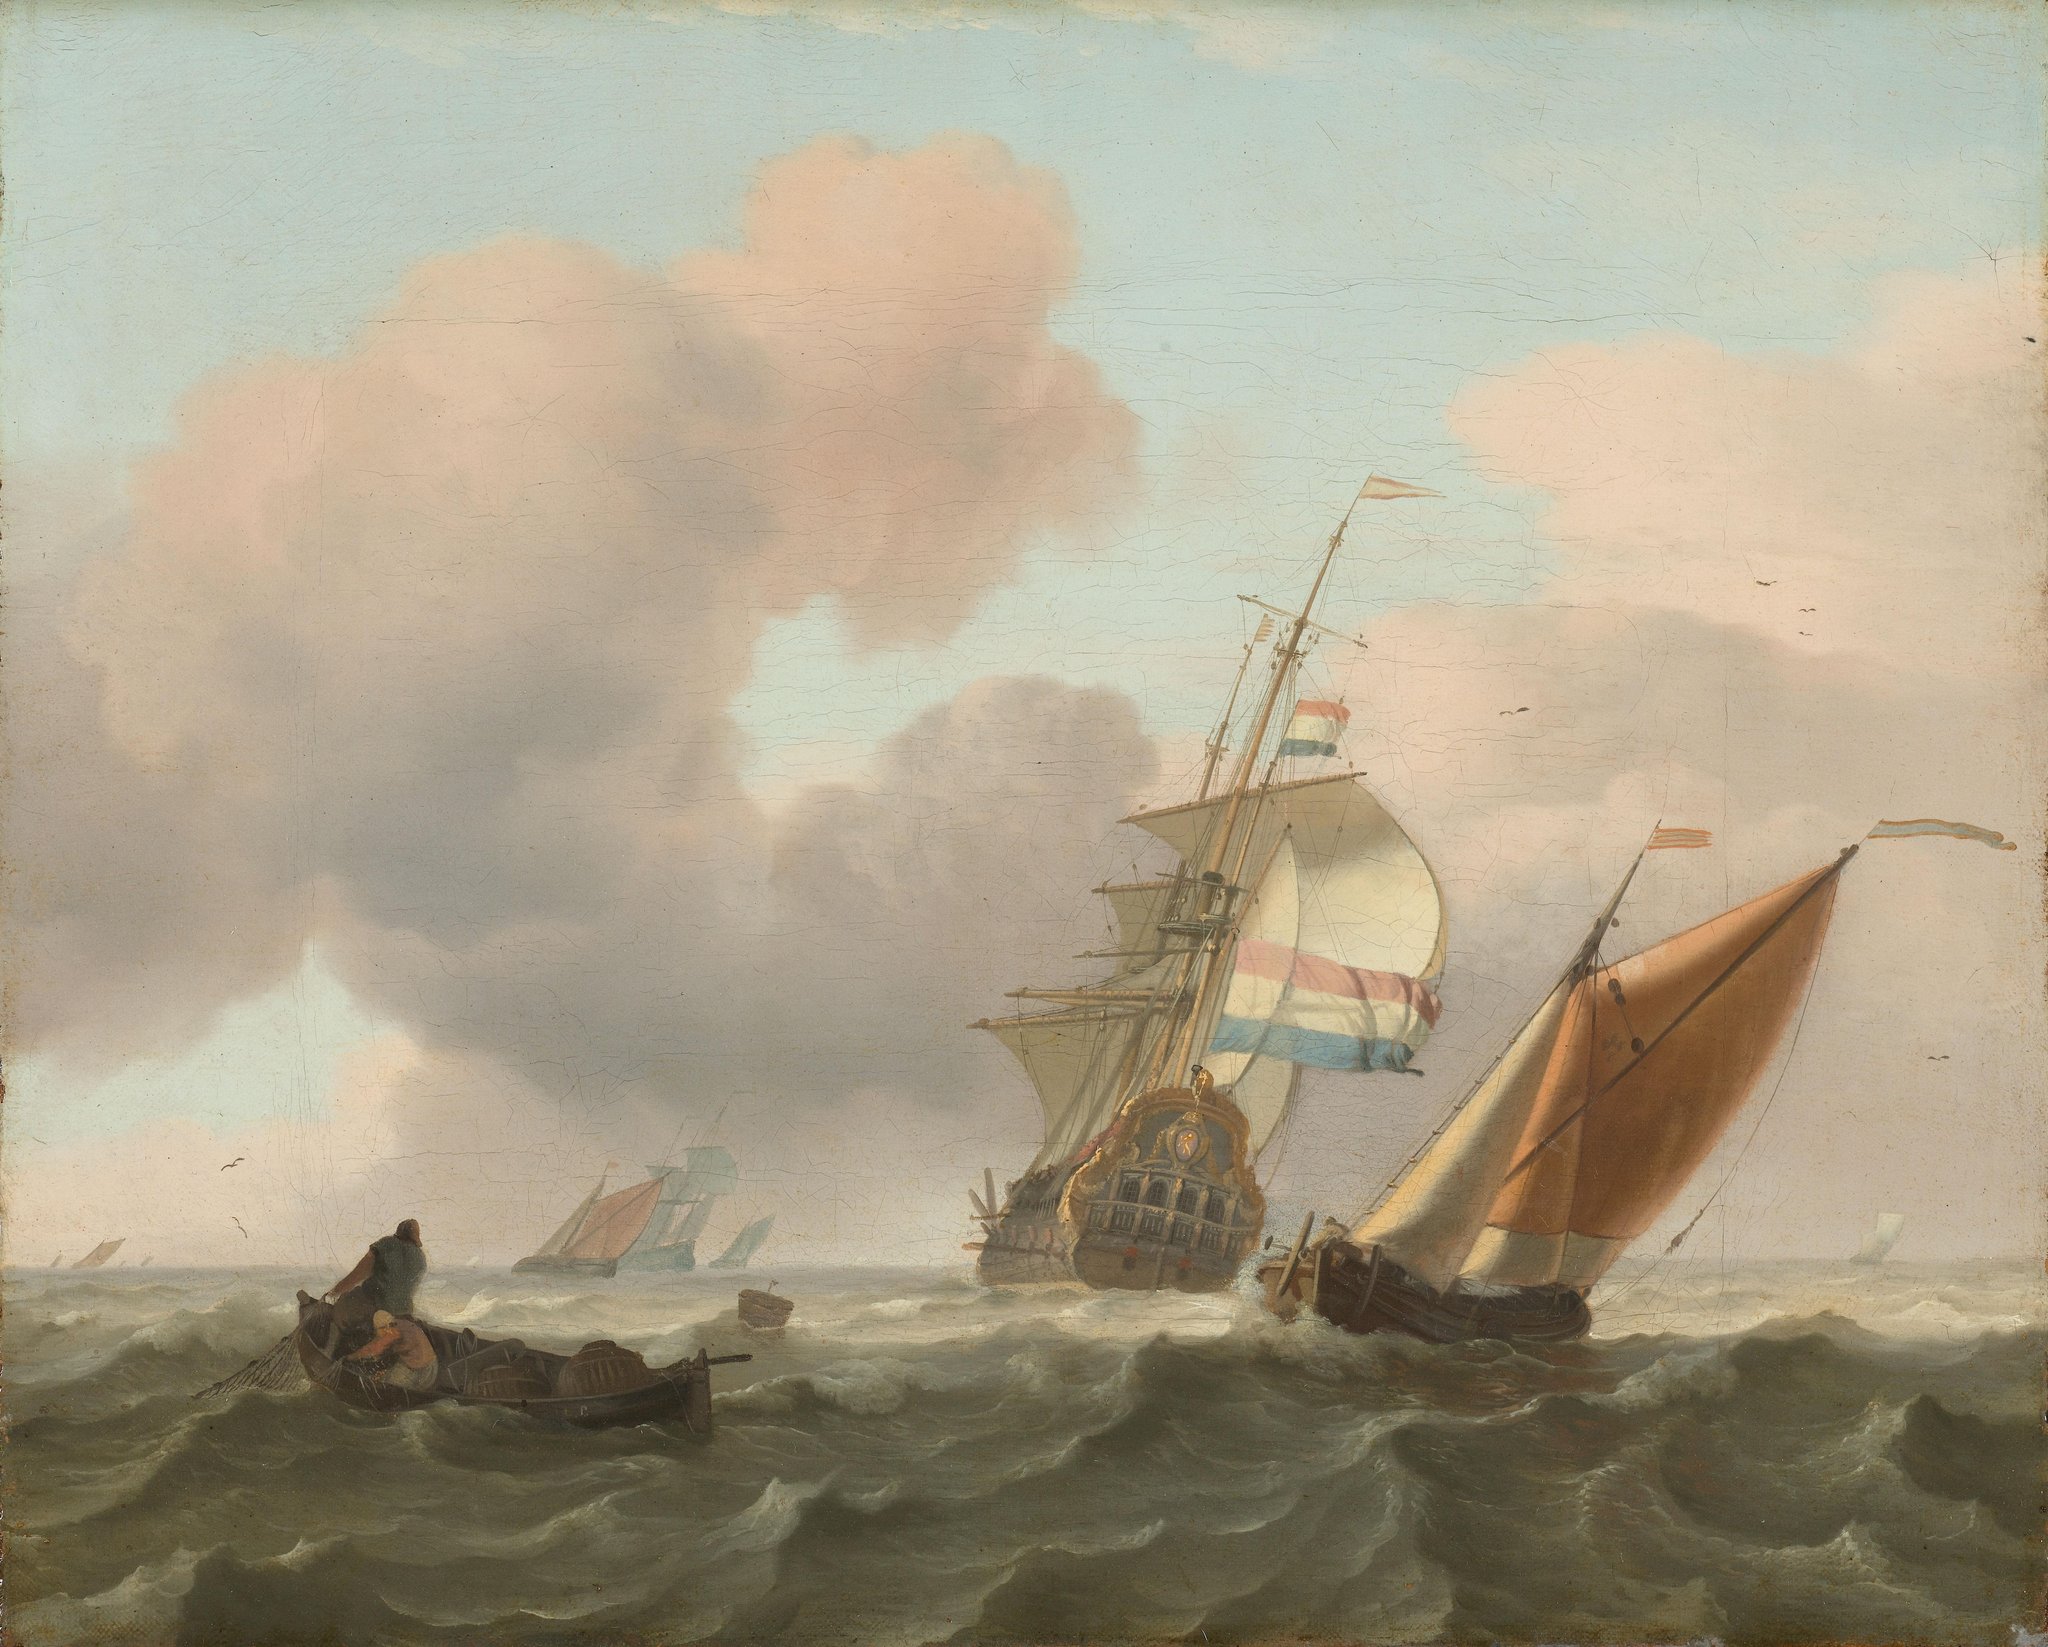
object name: painting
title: Rough Sea with Ships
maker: ludolf bakhuysen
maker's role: draughtsman, print maker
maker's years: 1631-1708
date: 1697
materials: canvas, oil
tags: sailing-ship, sailing-boat, storm at sea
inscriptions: signature and date: ‘L.B. 1697’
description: Woelige zee met schepen. Op de voorgrond een vissersbootje, rechts een tjalk, daarachter een oorlogsschip. Pendant van SK-A-2316.